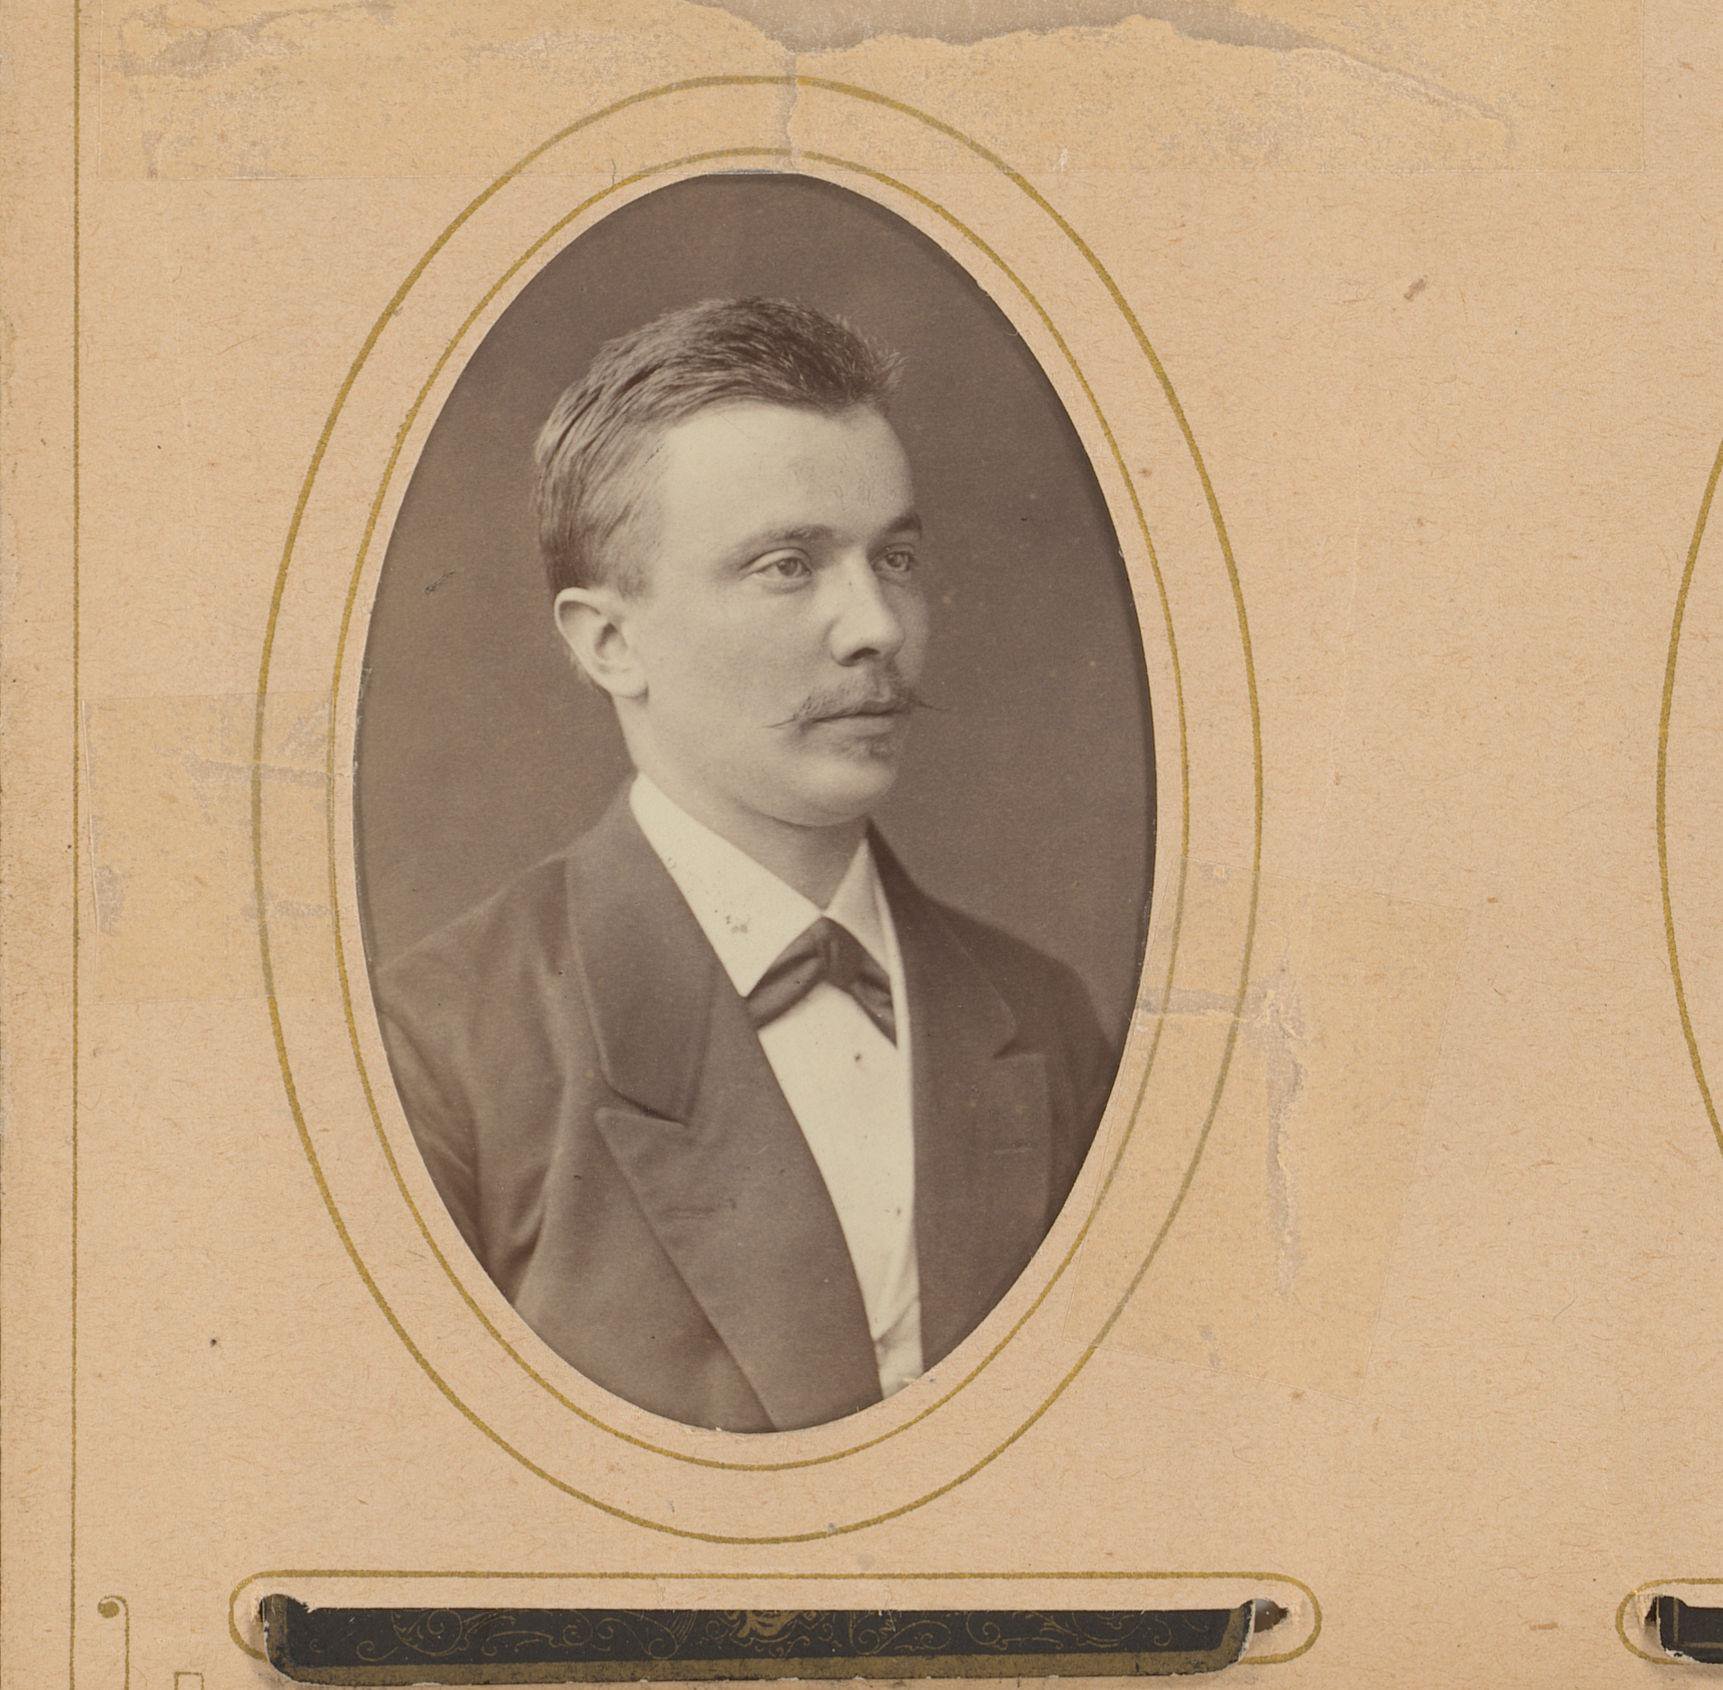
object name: album leaf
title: Portret van een man met snor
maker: ernst schroeter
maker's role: fotograaf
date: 1860-1900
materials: cardboard, photographic support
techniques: albumen print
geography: meissen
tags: moustache, historical persons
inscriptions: inscription: ‘E. SCHROETER/ Photographisches Atelier/ 597, OBERGASSE 597./ MEISSEN.’